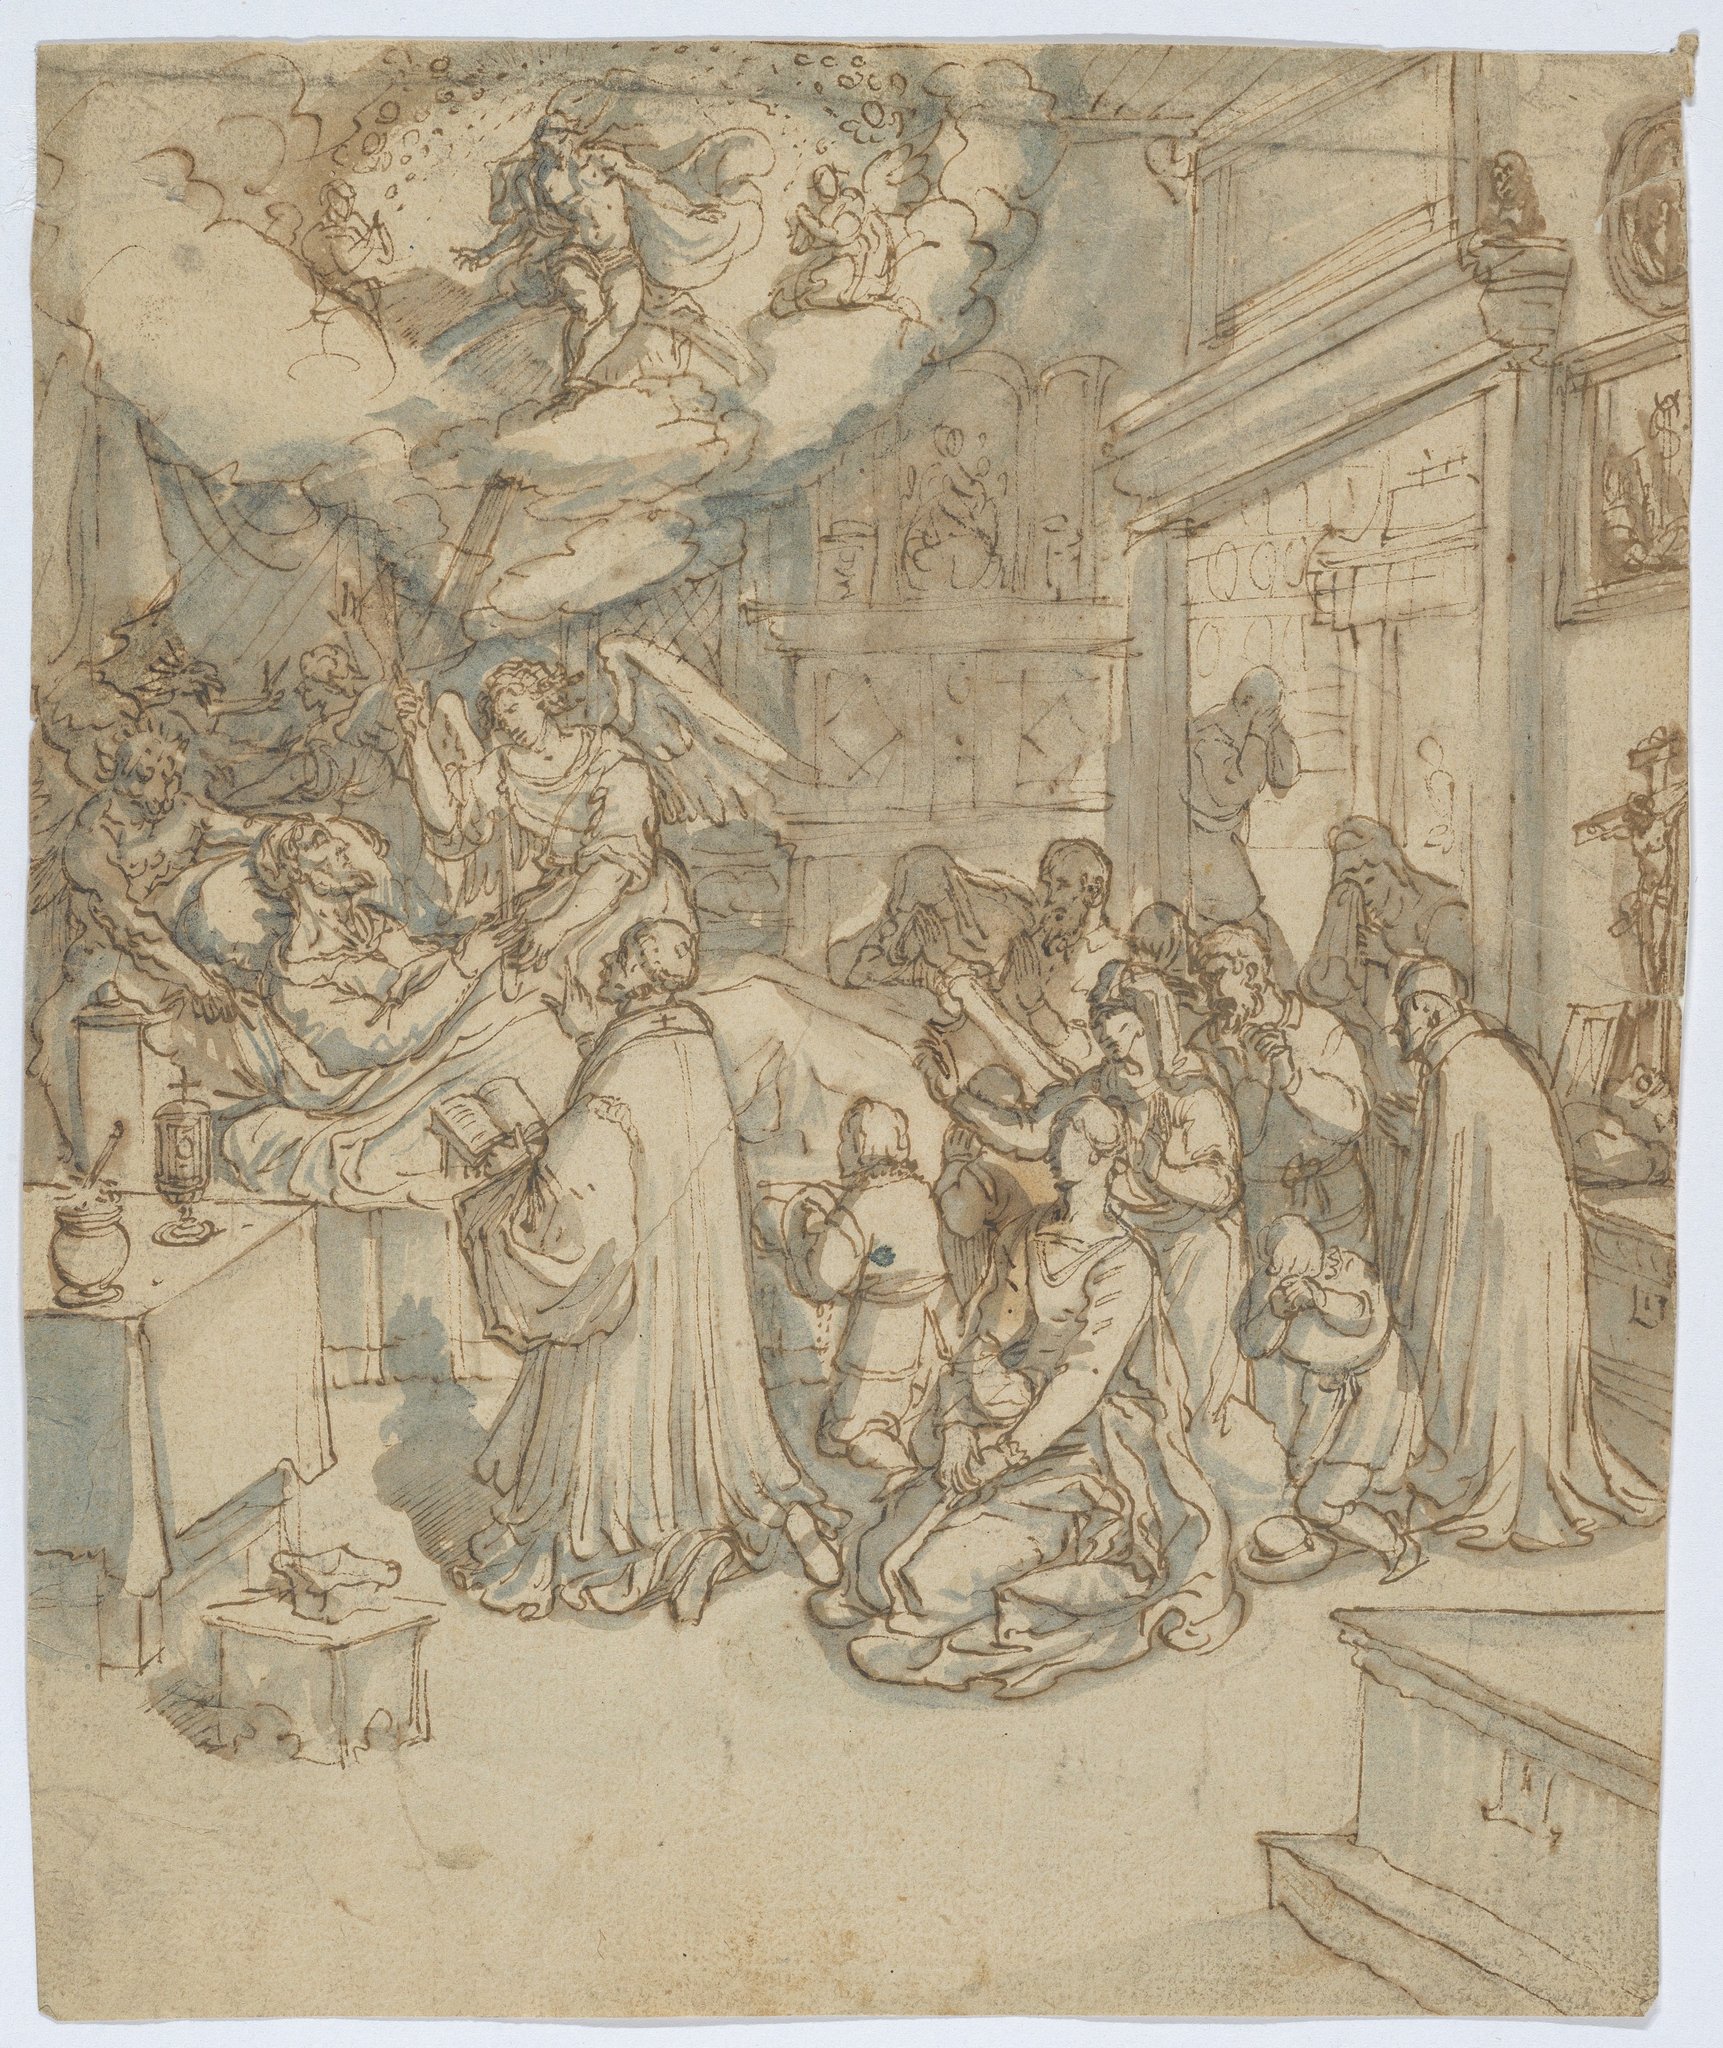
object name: drawing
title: Allegory of the Death of a Religious Man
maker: frans francken ii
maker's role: artist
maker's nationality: flemish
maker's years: 1581-1642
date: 1601-1633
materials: ink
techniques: brush, pen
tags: bedrooms,sadness,men,angels,death